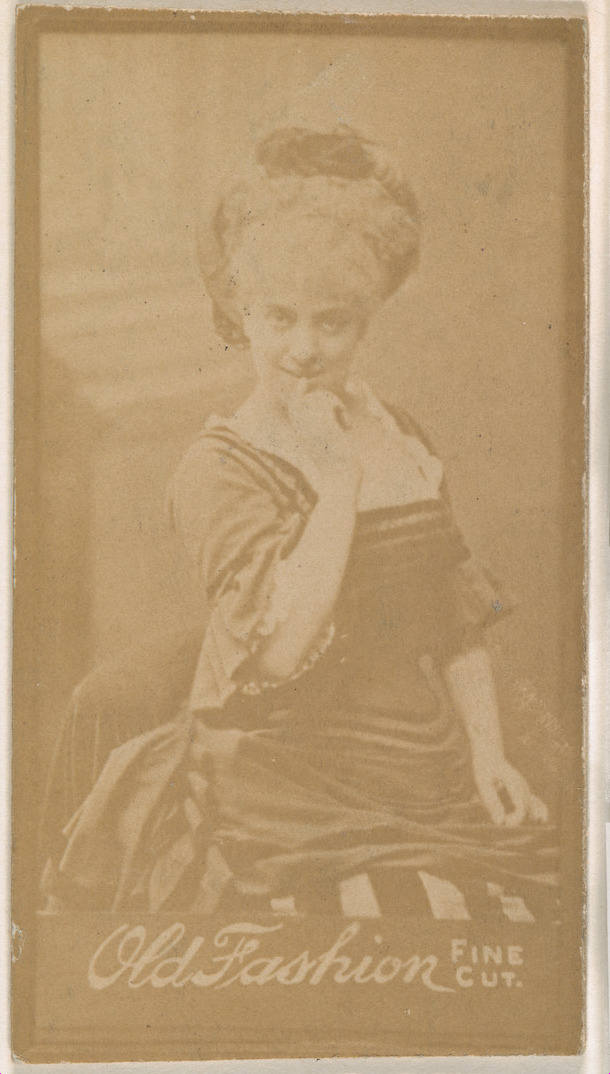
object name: photograph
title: Actress with finger held to lips, from the Actresses series (N664) promoting Old Fashion Fine Cut Tobacco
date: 1888-1890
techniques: albumen silver print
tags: portraits,women,actresses